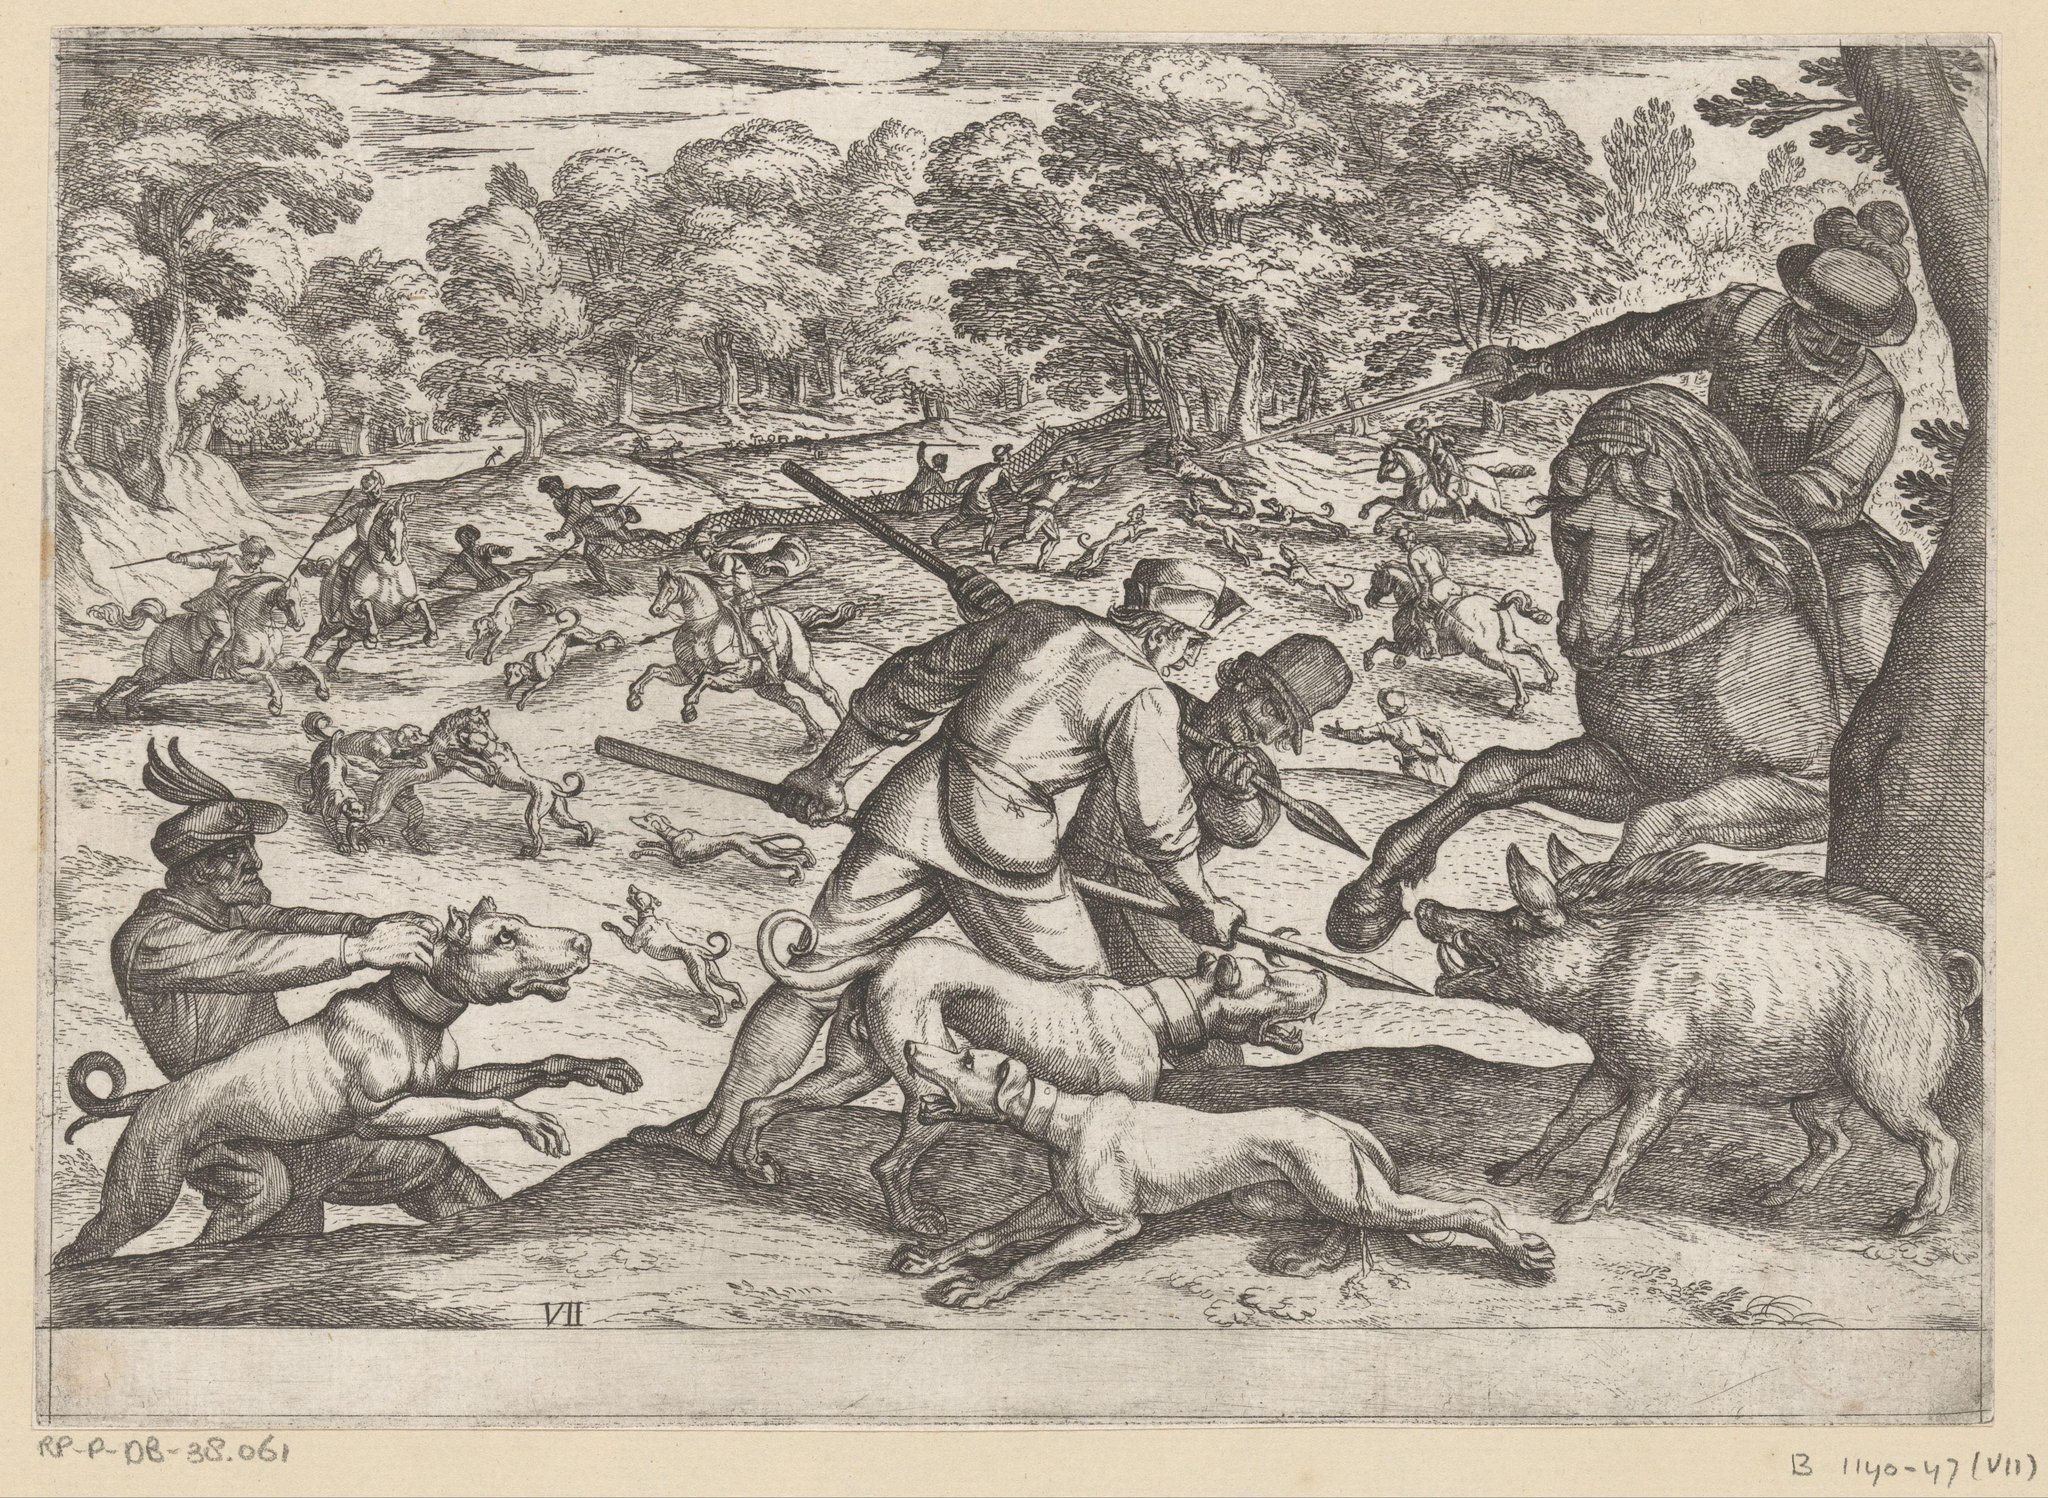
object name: print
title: Jachtscènes (deel 6)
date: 1609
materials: paper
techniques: etching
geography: rome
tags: boar-hunting, hunter, hunters hunting (n.b.: in 1988-1990 this notation denoted the concept of 43c11421 'hunters resting during the hunt'), beasts of prey, predatory animals: wolf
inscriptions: collector's mark: Lugt 240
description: Deze prent maakt deel uit van een reeks van negen prenten met jachtscènes (+ opdracht).